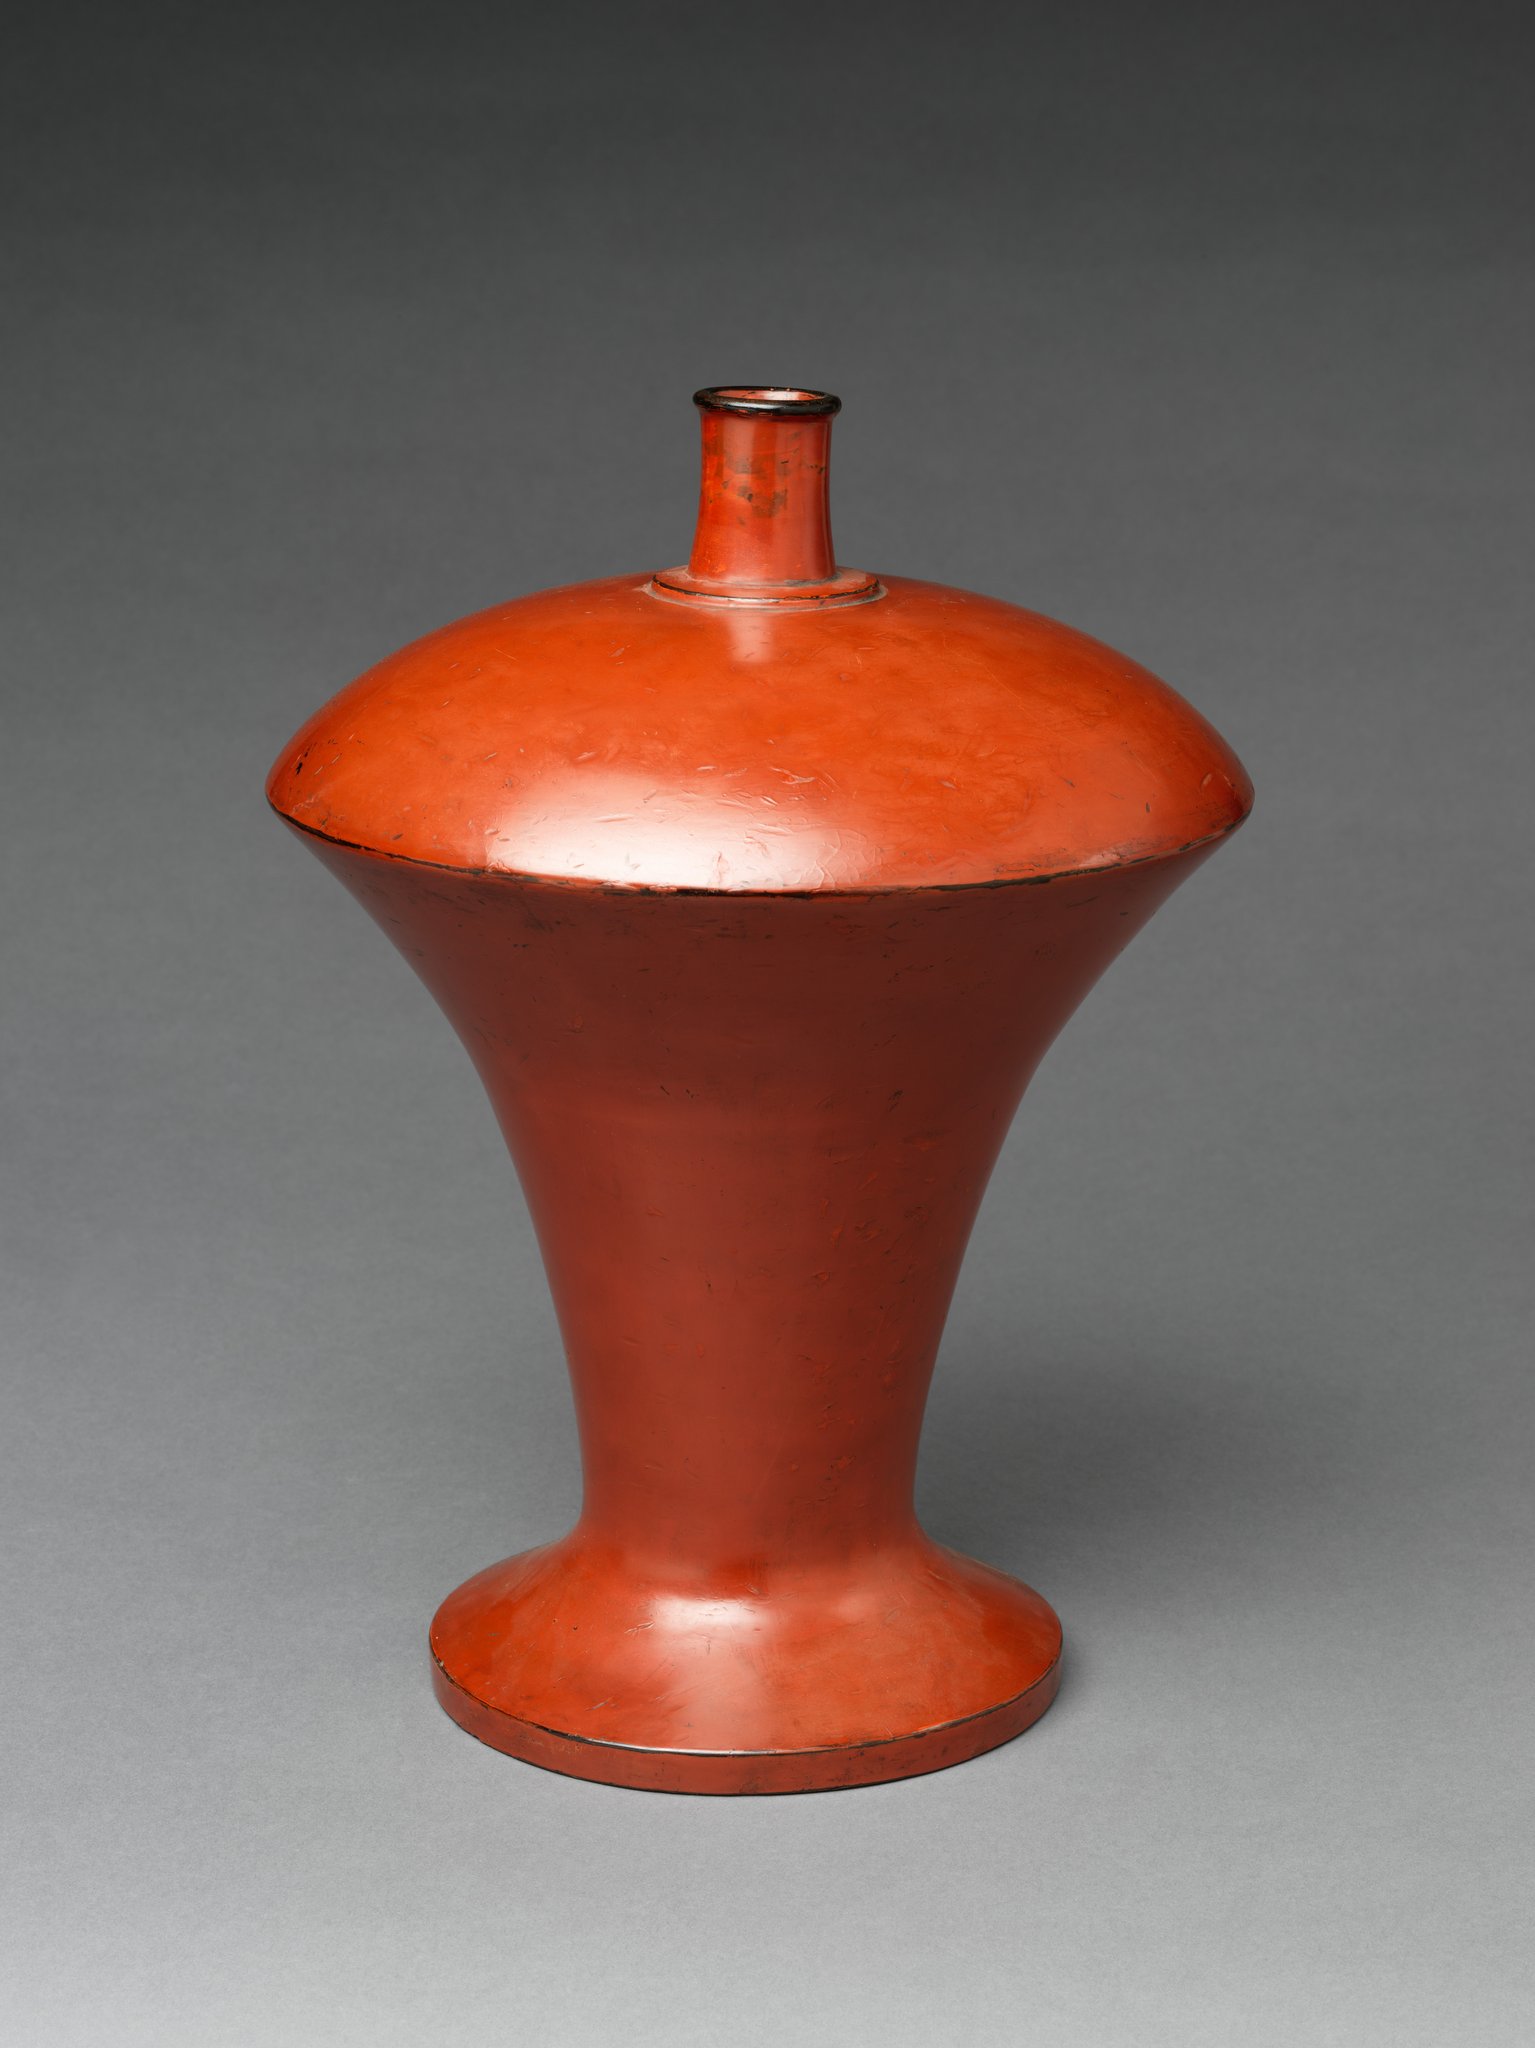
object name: sake vessel one of a pair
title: Sake vessel (Heishi)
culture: japanese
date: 1567-1600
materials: lacquer, wood